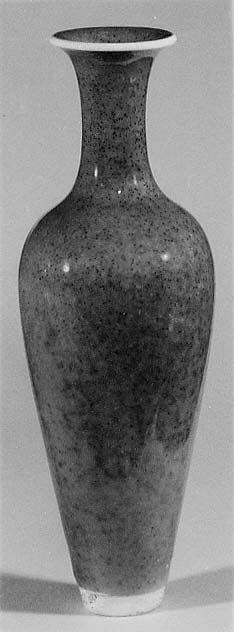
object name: vase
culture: chinese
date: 1700-1722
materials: glaze, porcelain